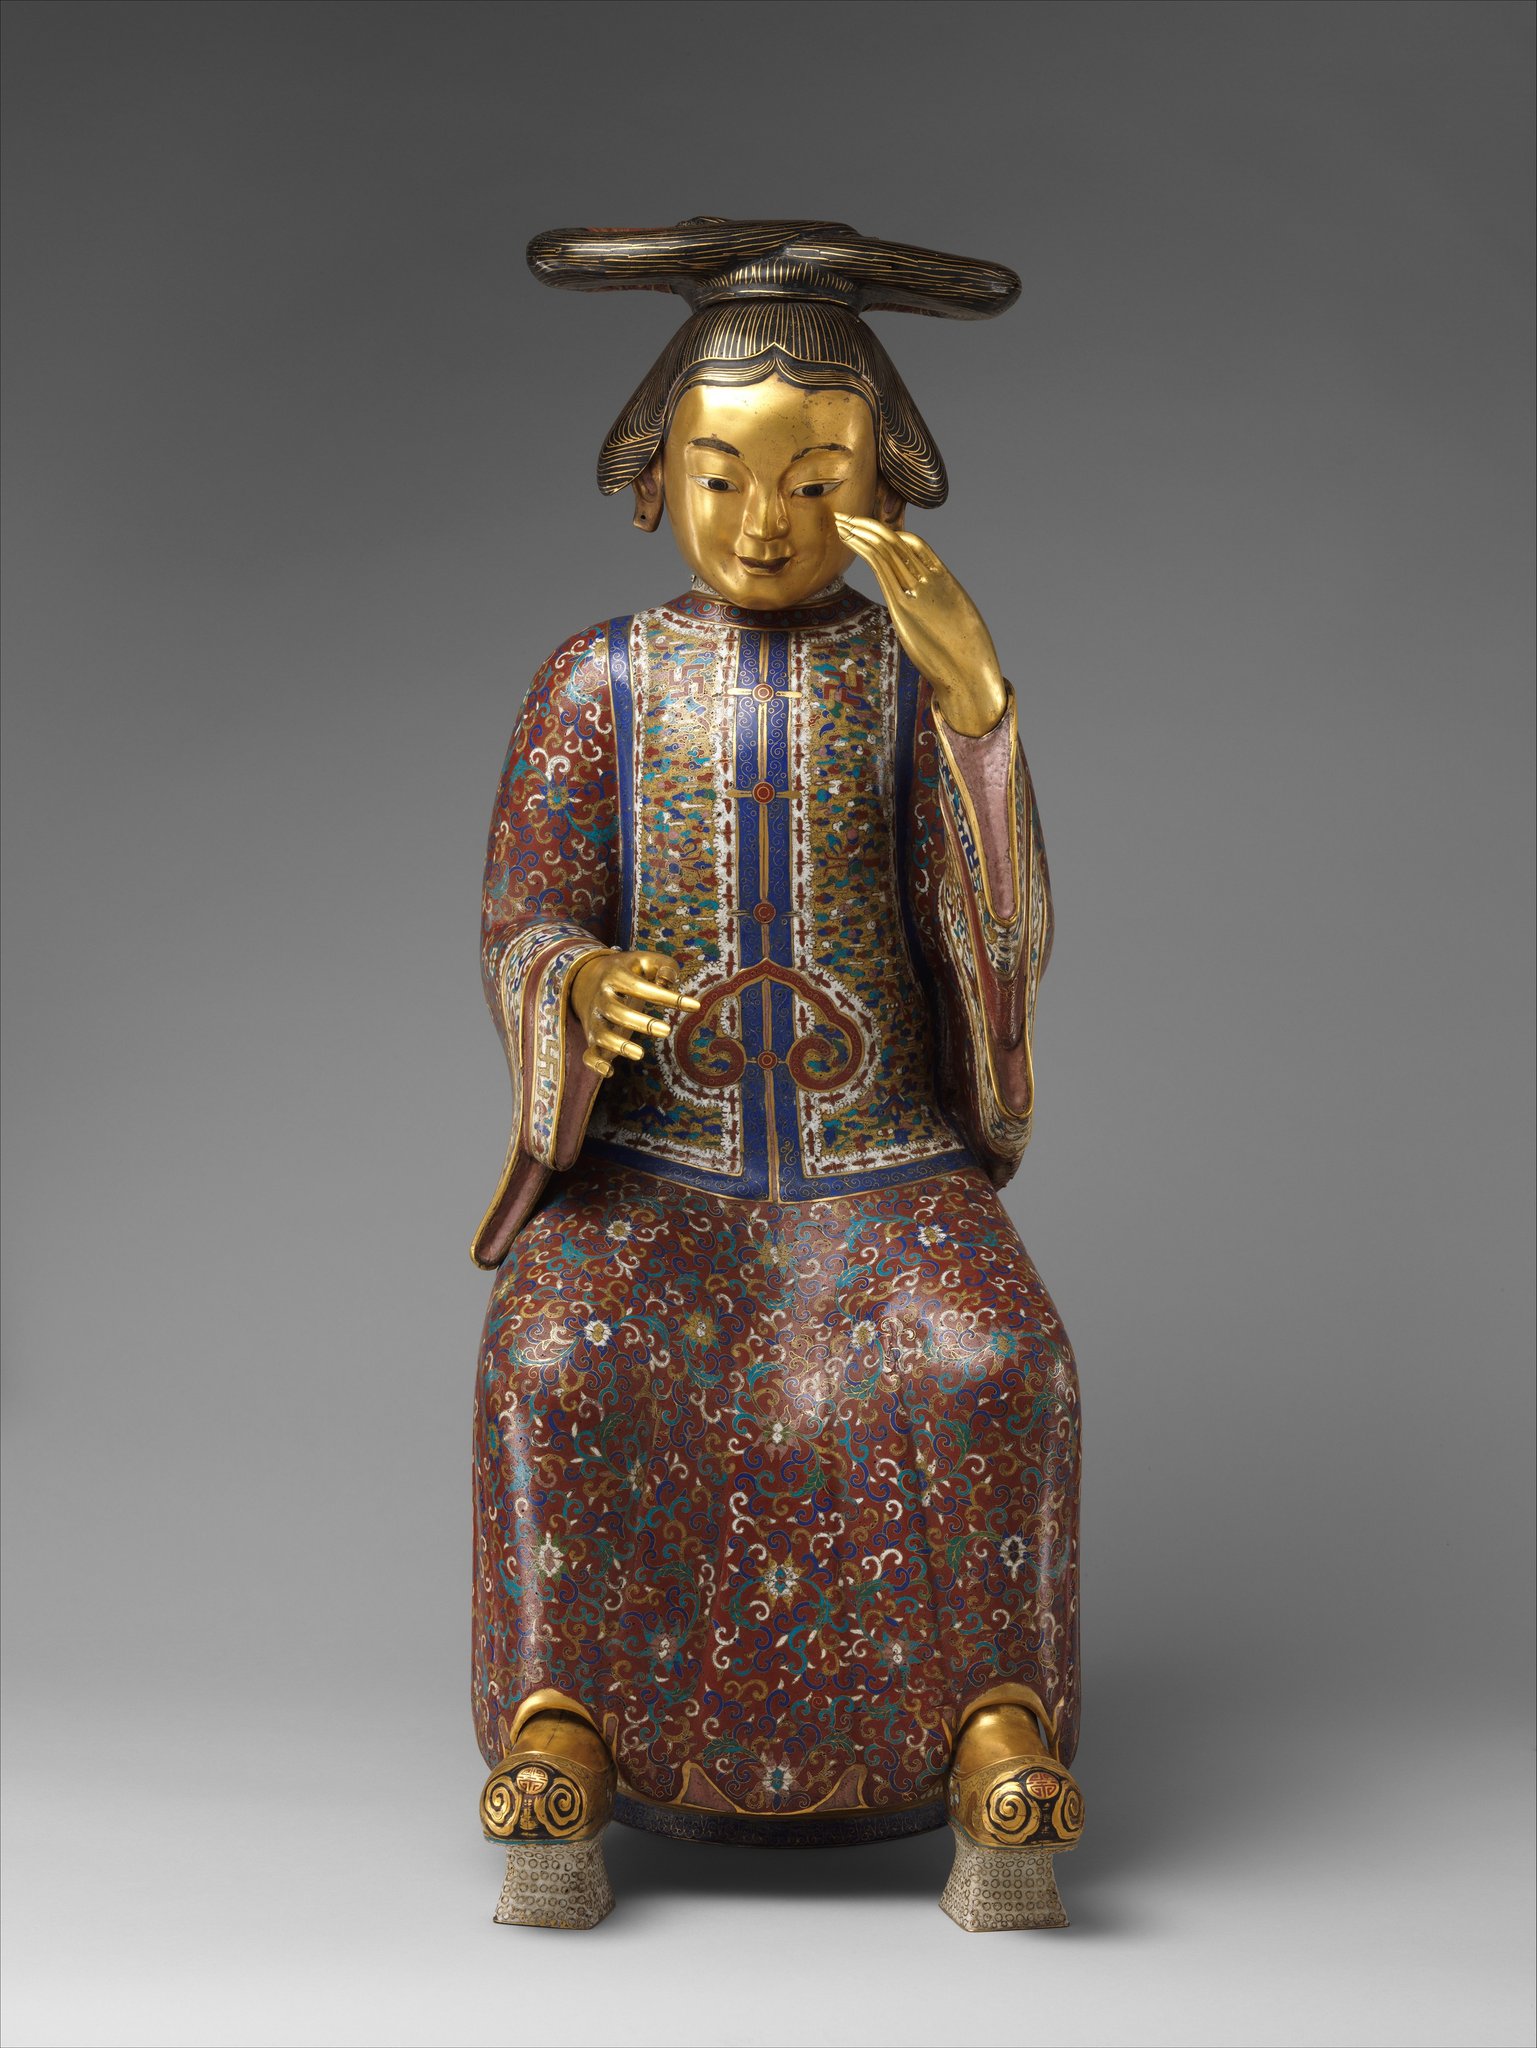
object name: figure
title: Seated Figure (one of a pair)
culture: chinese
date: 1736-1795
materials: enamel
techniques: enamel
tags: human figures